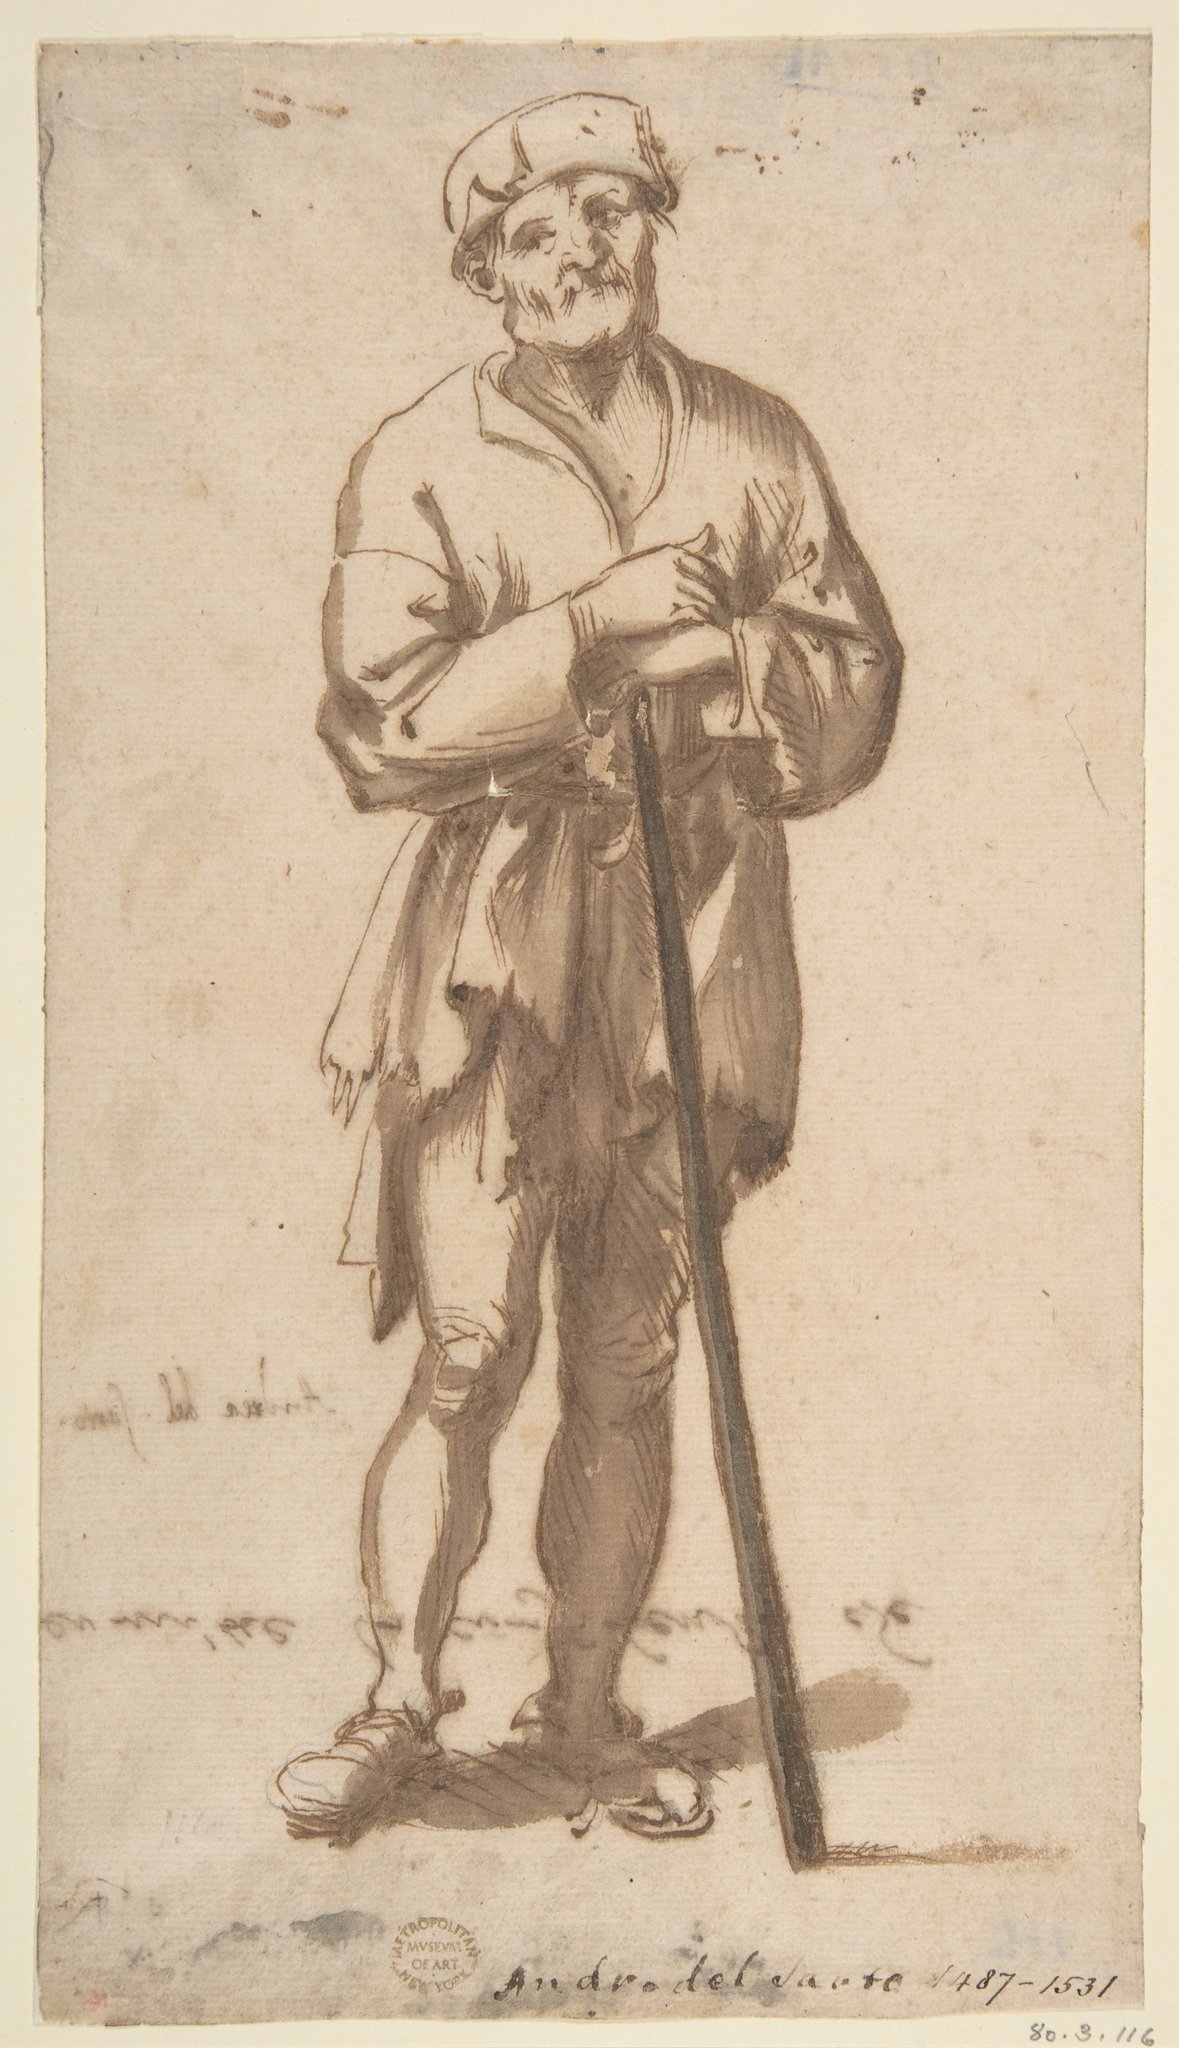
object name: drawing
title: Standing Old Man in Frontal View Leaning On a Staff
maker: anonymous, italian, roman-bolognese, 17th century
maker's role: artist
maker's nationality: italian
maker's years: 1600-1700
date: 1601-1700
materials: chalk, ink, paper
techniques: brush, pen, wash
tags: men